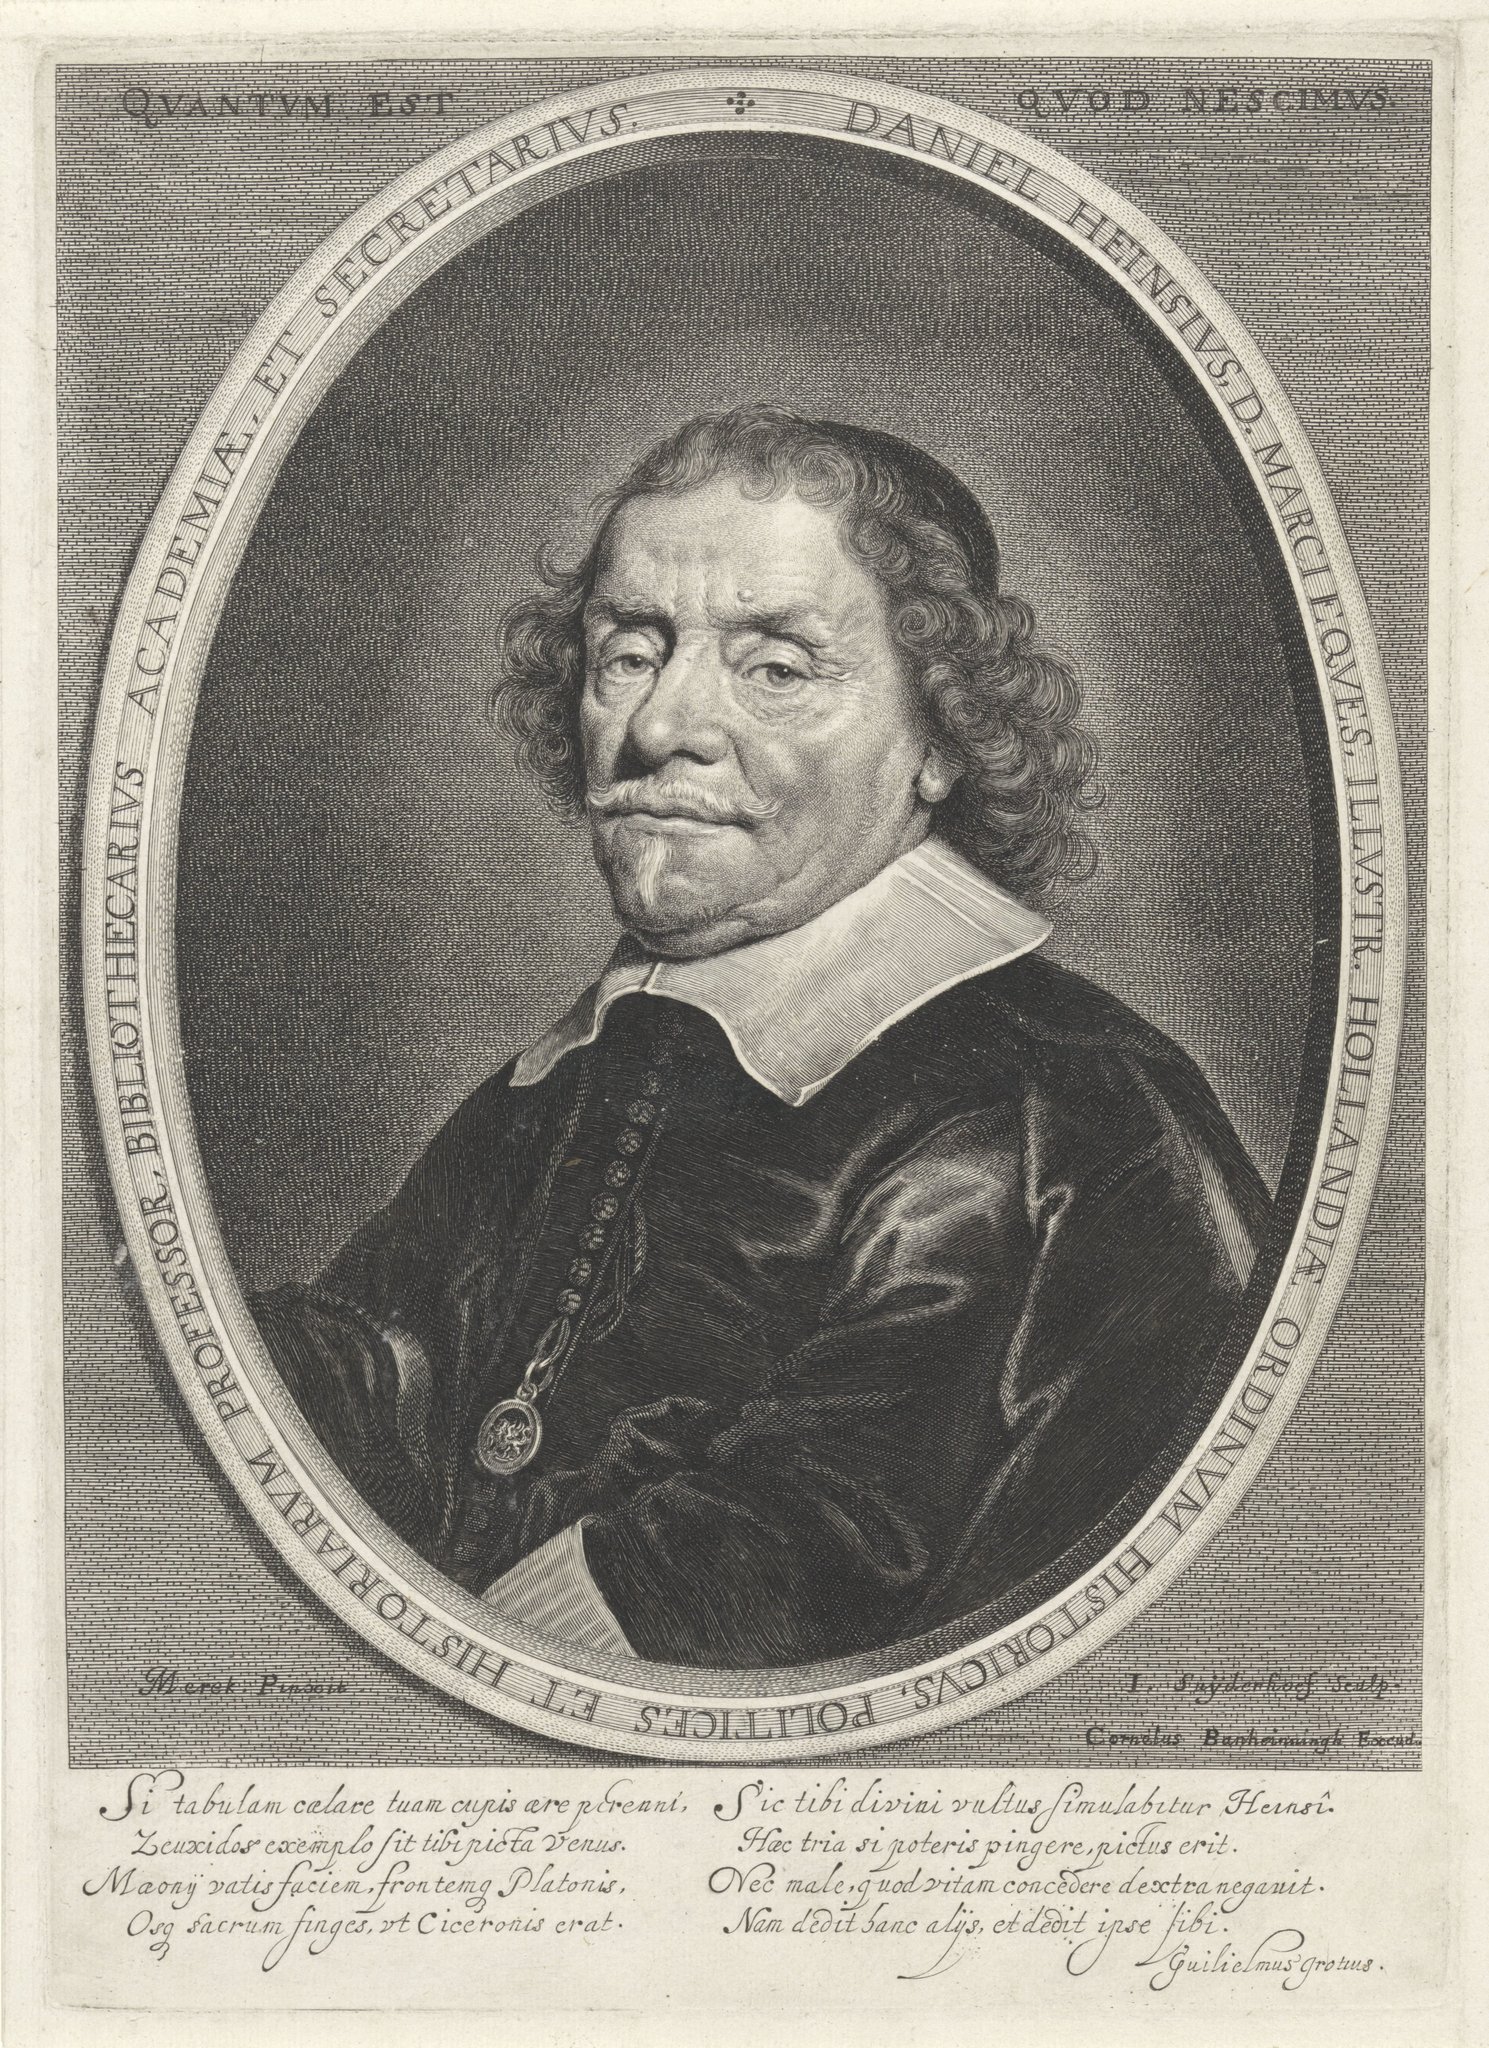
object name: print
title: Portret van Daniel Heinsius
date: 1647-1665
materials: paper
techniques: engraving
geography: haarlem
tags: ghent, leiden, daniël heinsius, professor (+ portrait of teacher, professor)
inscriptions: collector's mark: Lugt 240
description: Portret van Daniel Heinsius, hoogleraar staatkunde en geschiedenis, universiteitsbibliothecaris en secretaris aan de universiteit van Leiden. Onderaan in de marge een twee vierregelige verzen in het Latijn.